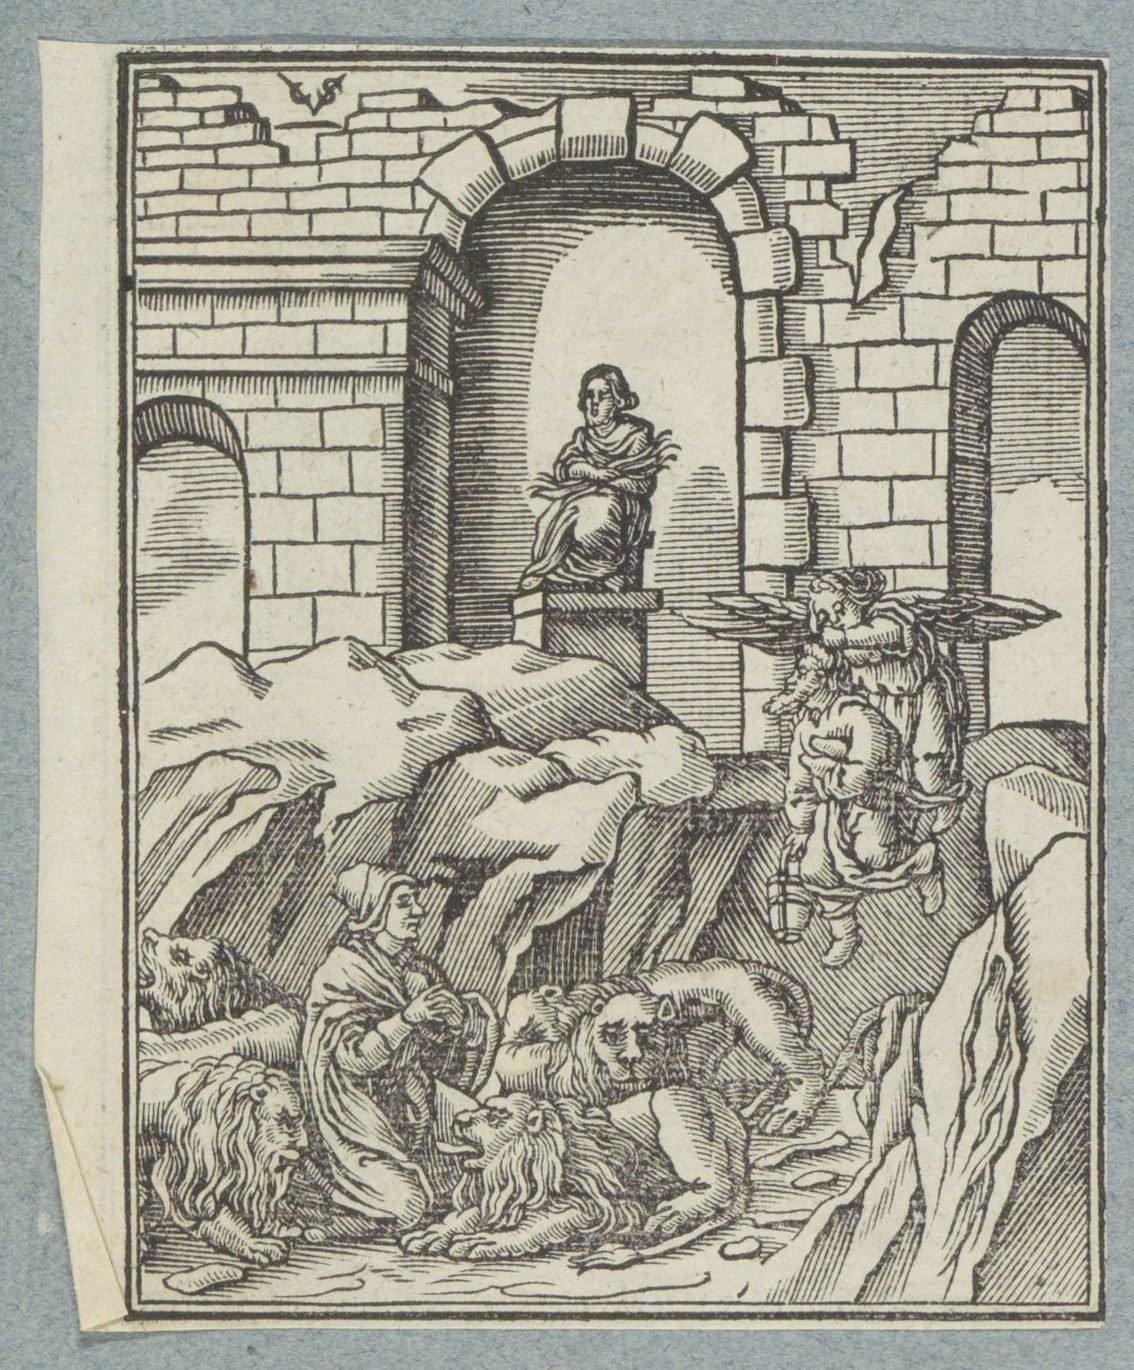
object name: album leaf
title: Daniël in de leeuwenkuil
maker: pieter jacobsz. paets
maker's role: publisher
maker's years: 1587-1667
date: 1645-1646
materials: paper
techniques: woodcut, pasting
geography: amsterdam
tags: the prophet habakkuk, carried by his hair by an angel, brings food to daniel who sits unharmed between the lions, daniel's punishment and liberation: daniel in the lion's den ~ king darius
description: De prent werd gemaakt voor de uitgaven van P.J. Paets uit Amsterdam. Ze komt in ieder geval voor in: Bibels Tresoor ofte der zielen lusthof. Amsterdam, P.J. Paets, 1646. Mogelijk ook in: Historien ende Prophetien. [Amsterdam], P.J. Paets, 1645.